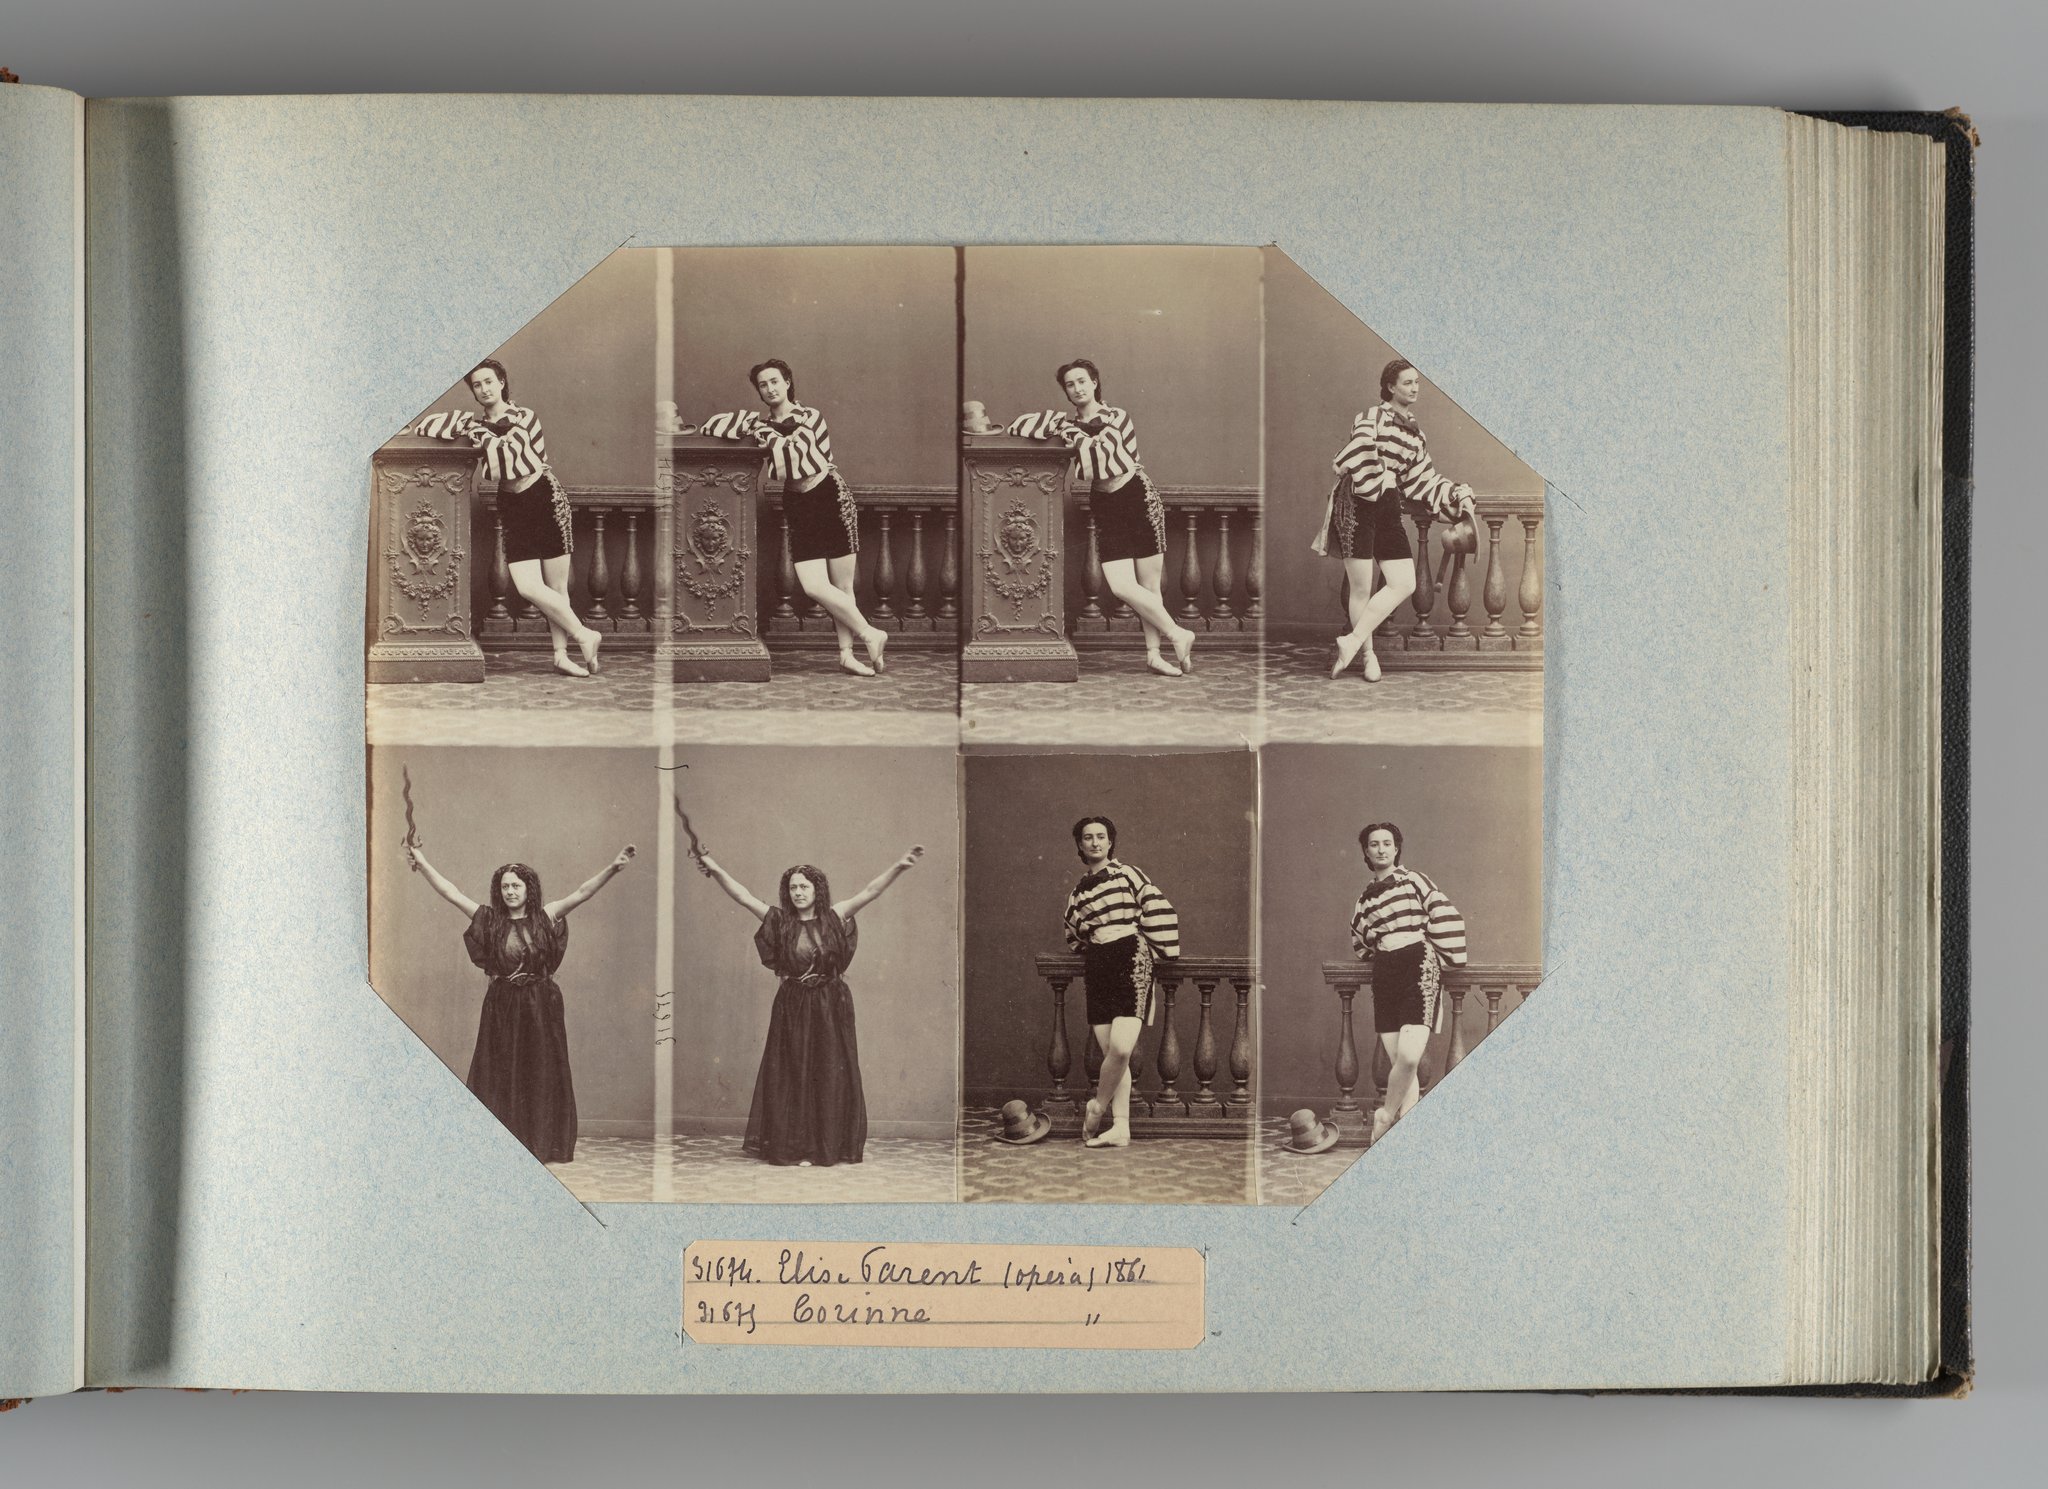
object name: photograph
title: Elise Parent; Corinne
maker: andré-adolphe-eugène disdéri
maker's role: artist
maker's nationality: french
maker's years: 1819-1889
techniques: albumen silver print, glass negative